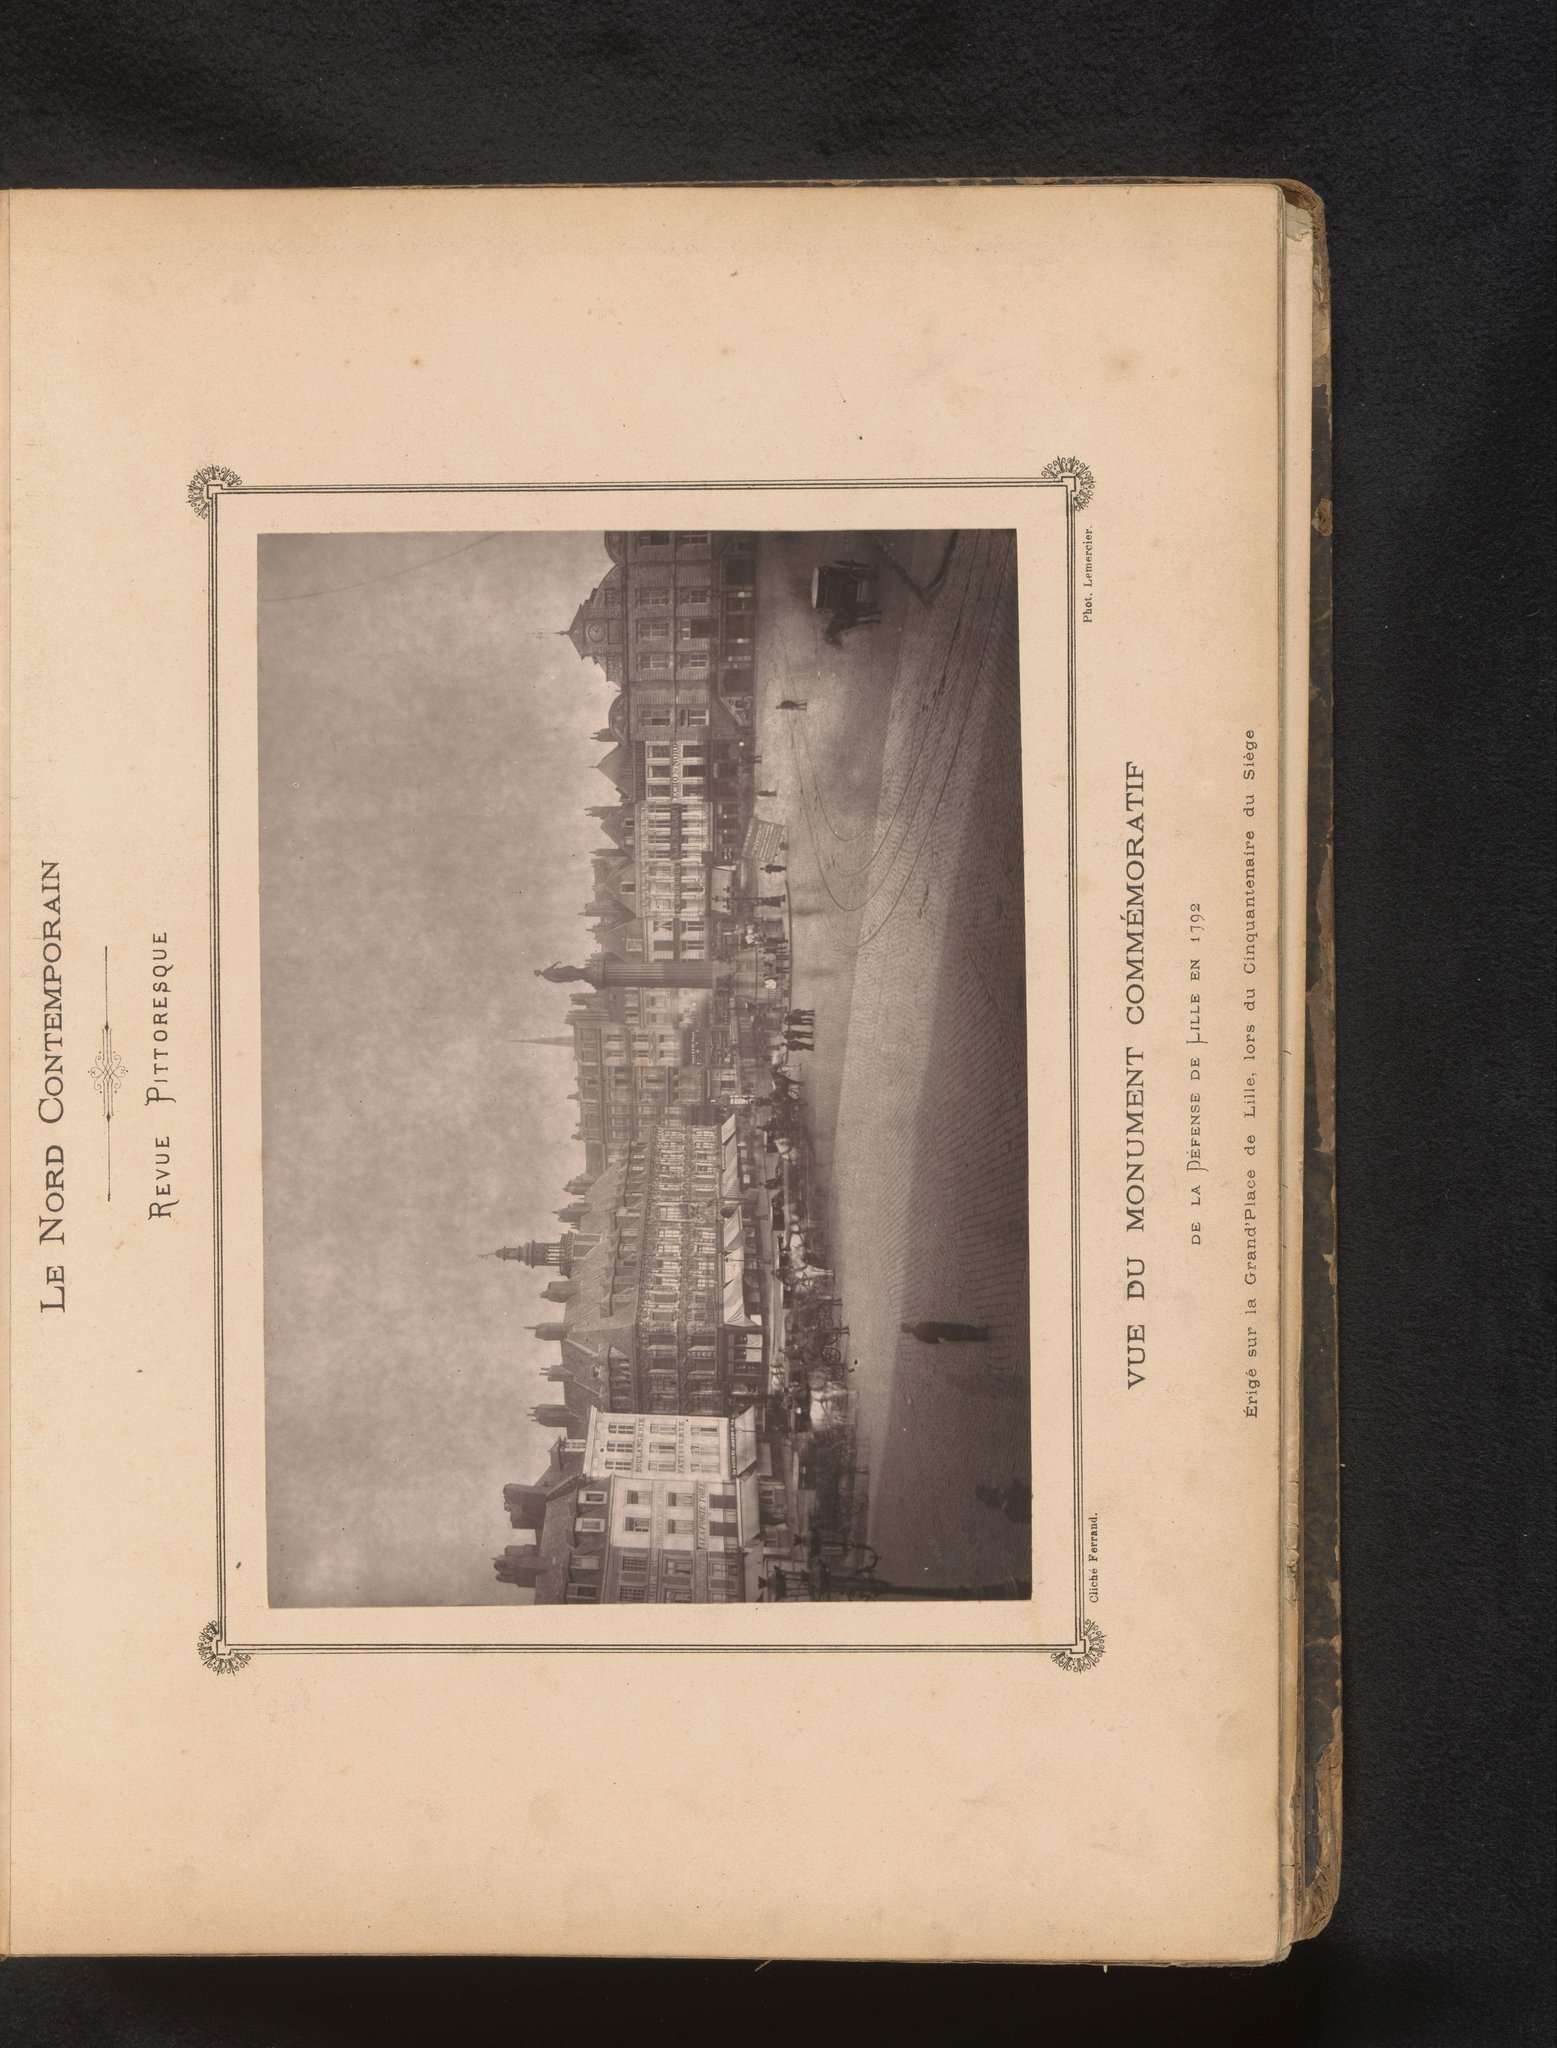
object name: photomechanical print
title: Gezicht op de zuil La Colonne de la Déesse op het Place de Général du Gaulle in Lille, ter nagedachtenis aan het verzet tegen de Oostenrijkers in 1792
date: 1877-1882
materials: paper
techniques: woodburytype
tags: square, place, circus, etc., monument, statue, lille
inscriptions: inscription: ‘Érigé sur la Grand'Place de Lille, lors du Cinquantenaire du Siège’, inscription: ‘Le Nord Contemporain/ Revue Pittoresque’